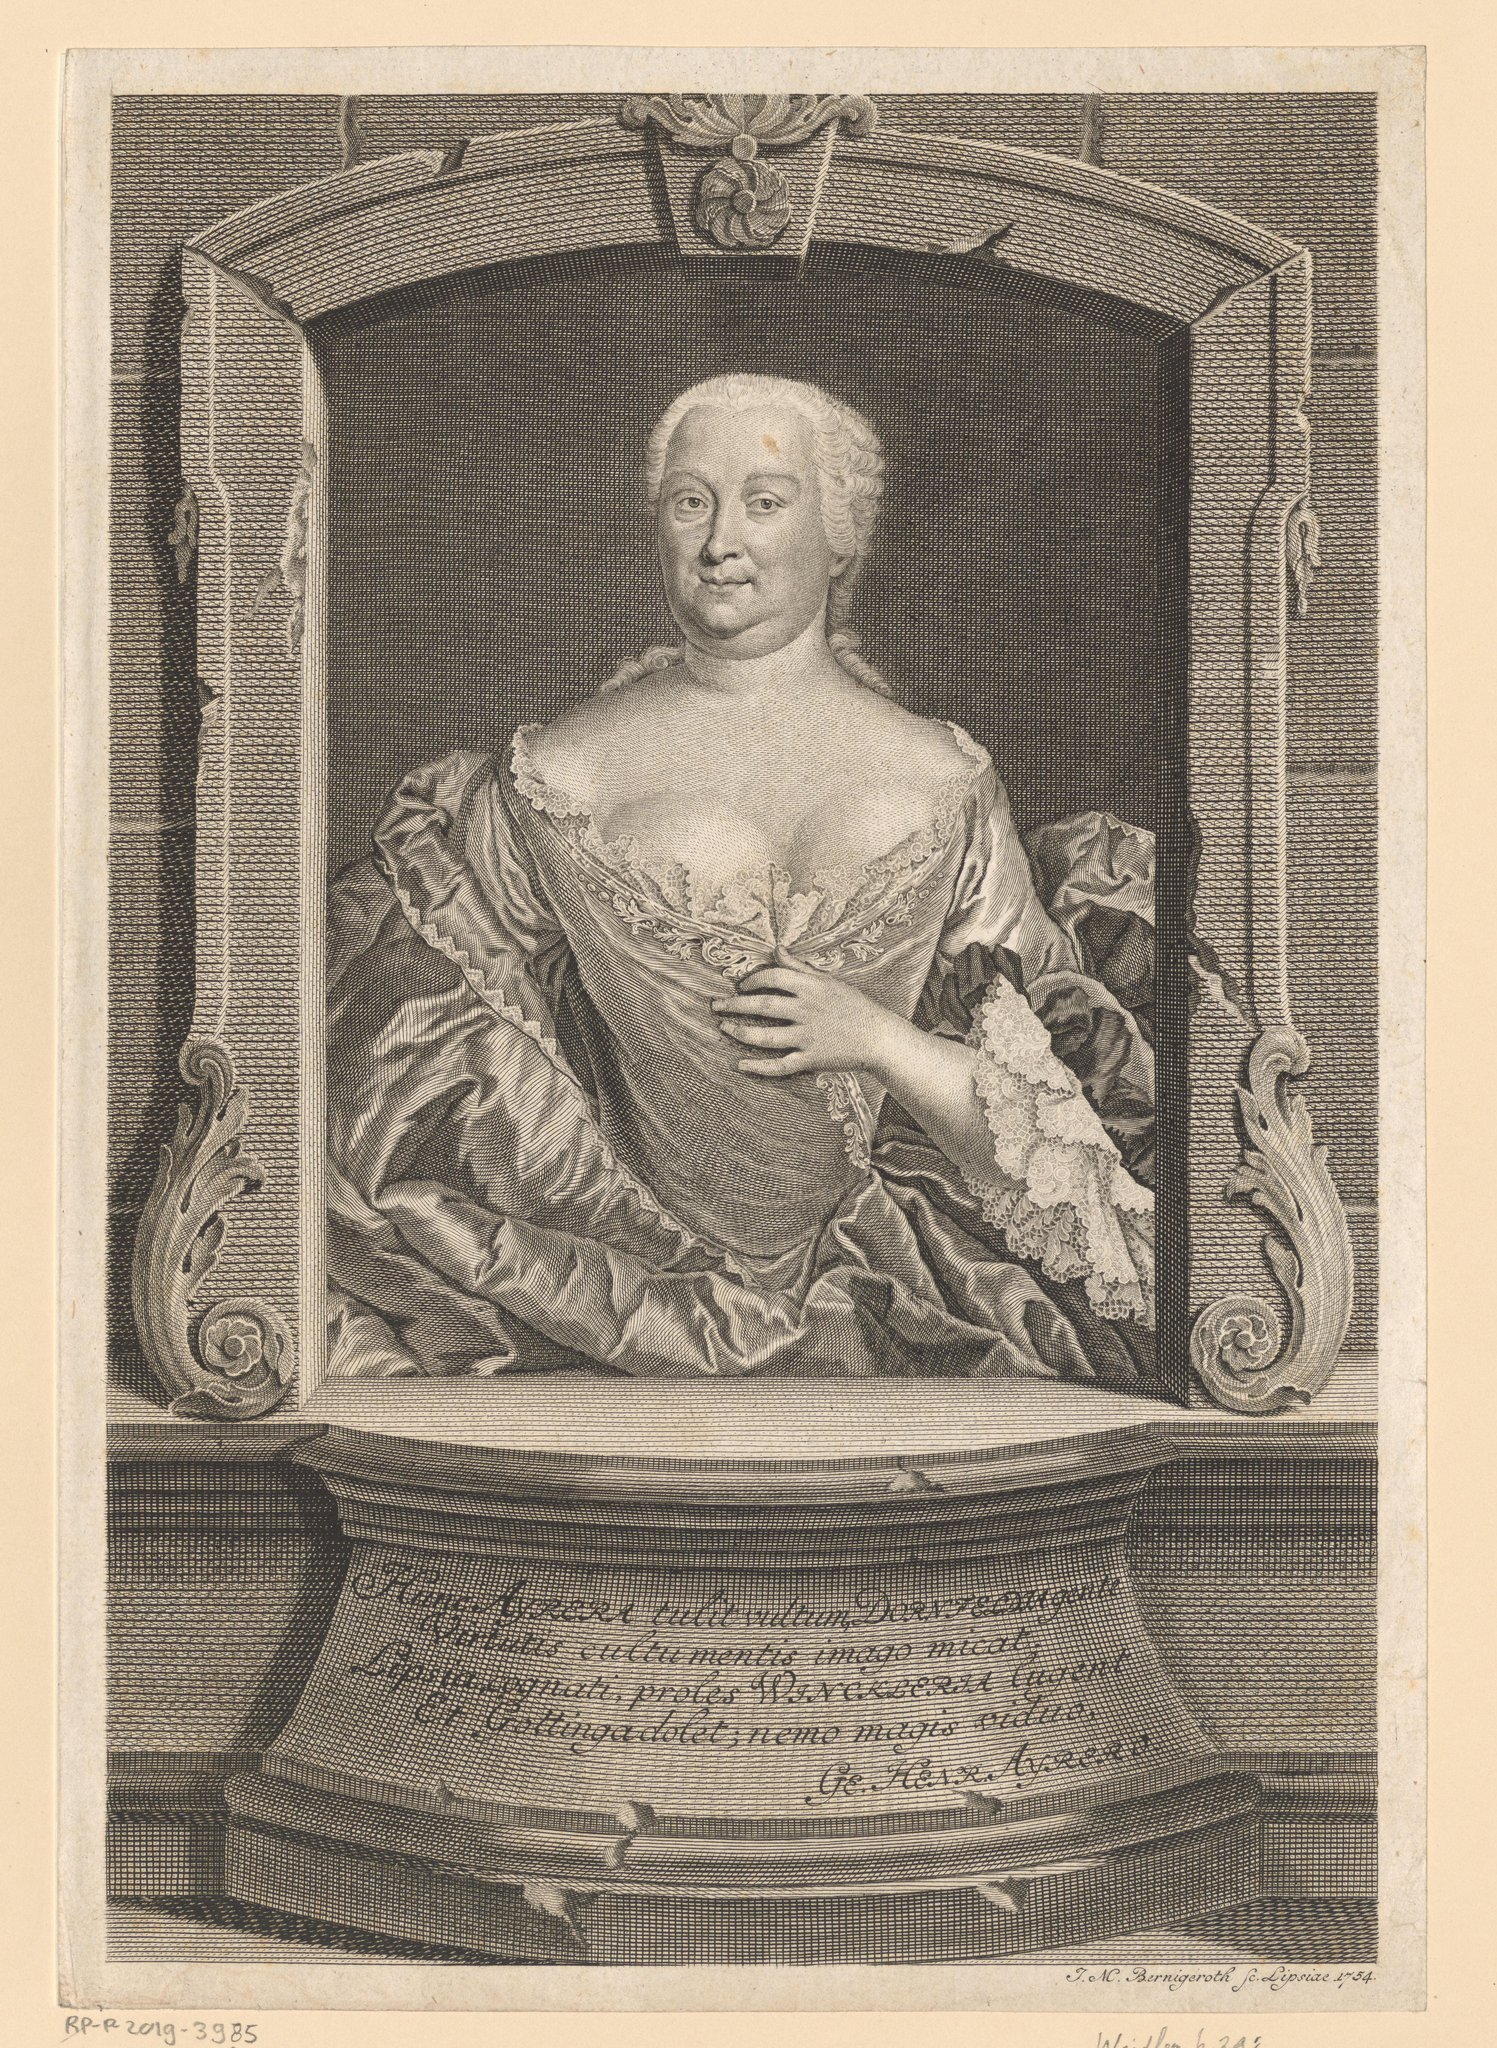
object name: print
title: Portret van Georg Heinrich Ayrer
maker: johann martin bernigeroth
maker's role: print maker, publisher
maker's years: 1713-1767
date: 1754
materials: paper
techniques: engraving, etching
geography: leipzig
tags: georg heinrich ayrer, historical persons, dress, gown: day dress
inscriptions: date